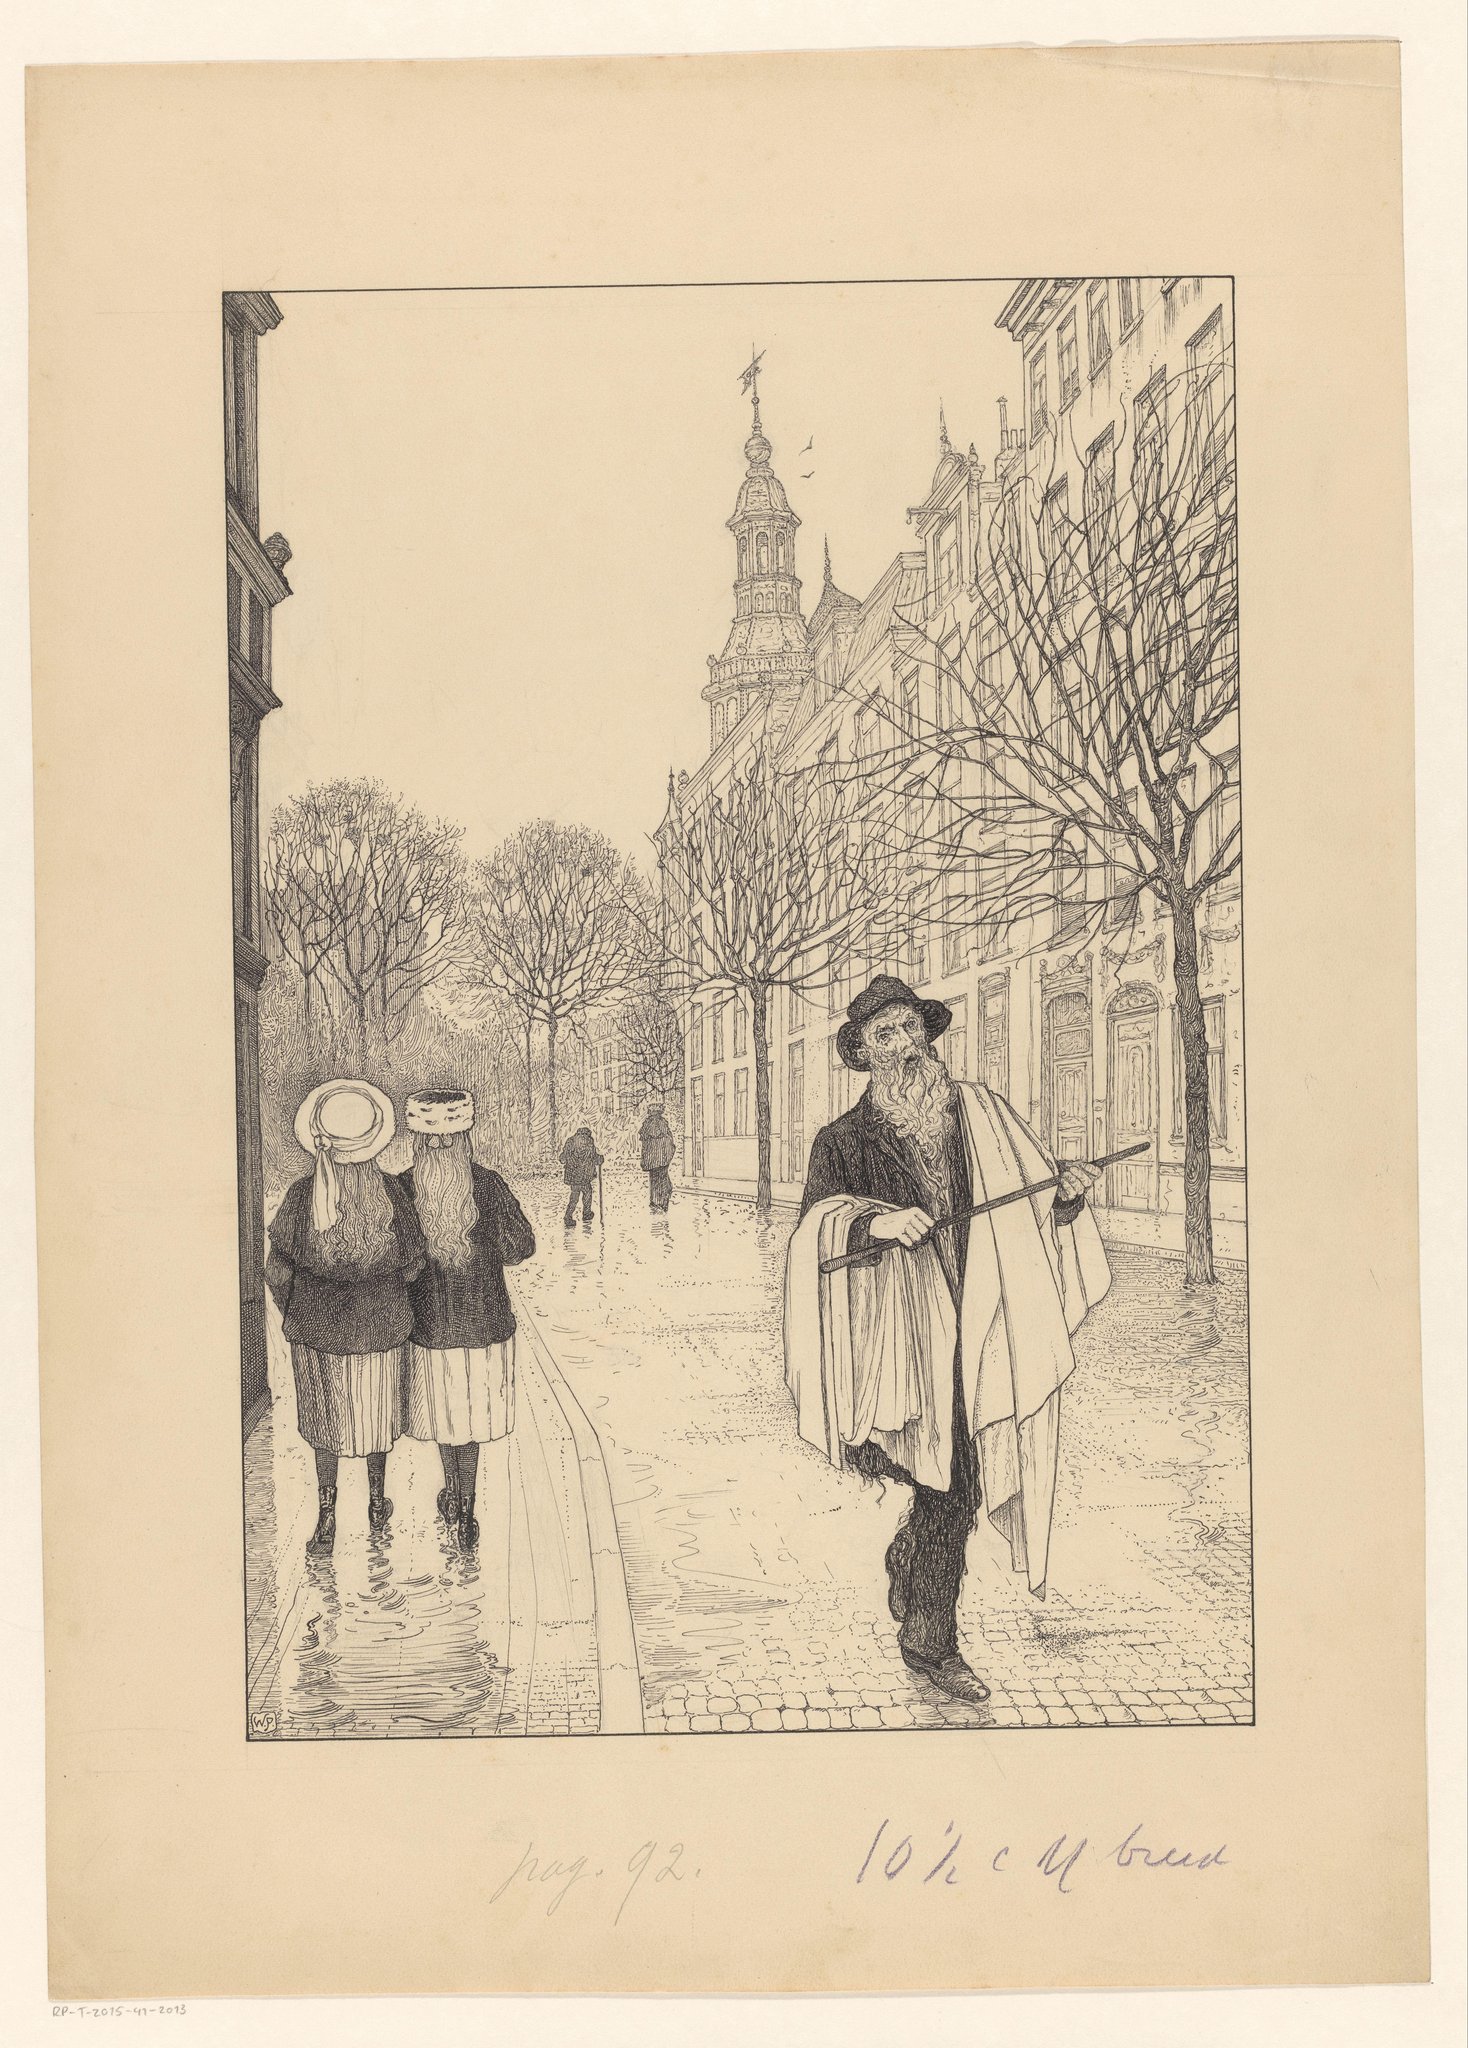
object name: boekillustratie ontwerp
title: Oude man met stok op een straat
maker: willem pothast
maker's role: draughtsman, print maker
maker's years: 1877-1916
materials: ink, paper, pencil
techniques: pen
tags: walking-stick, staff, walking (+ old male (human being)), drapery, draped garment, 'gewandgebung', street (+ city(-scape) with figures, staffage)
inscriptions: collector's mark: Lugt 2228, annotation: ‘pag. 92.’, :, signature: ‘W.P.’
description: Een oude man met een baard loopt met een stok over een natte straat. Hij heeft een lap stof om zijn arm en schouder gedrapeerd.